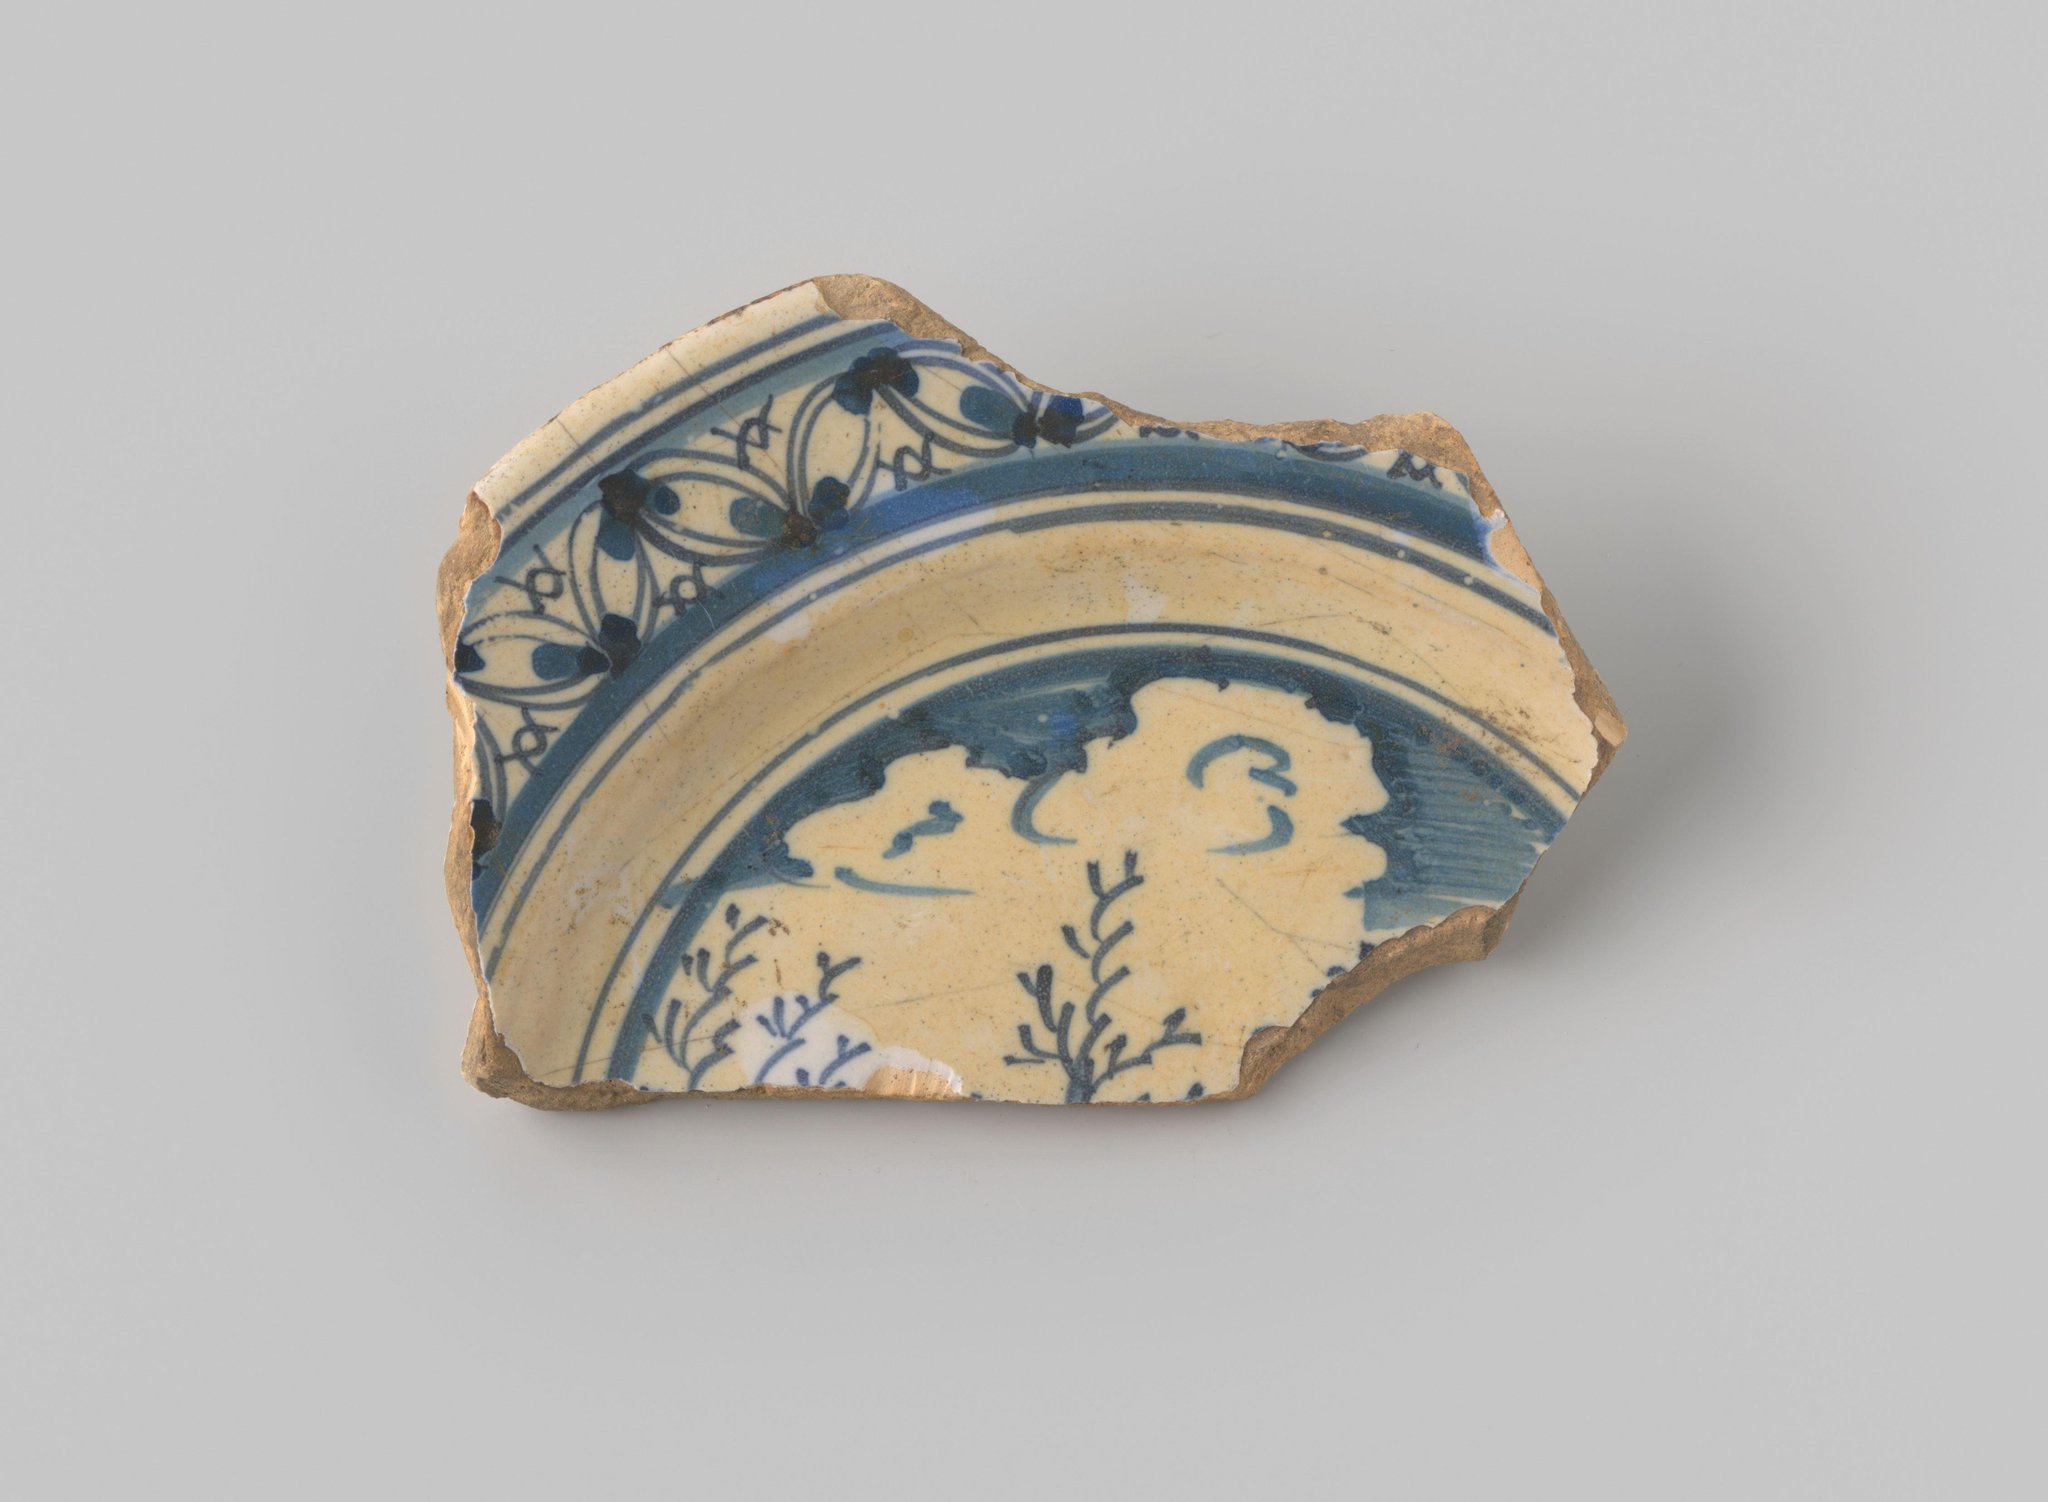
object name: sherd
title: Scherf van gelig bakkend aardewerk, voorzien van wit glazuur, aan de voorzijde voorzien van een sierrand en een schildering van een lucht met bomen in blauw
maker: Anonymous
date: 1600-1650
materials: earthenware, glaze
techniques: maiolica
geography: northern netherlands